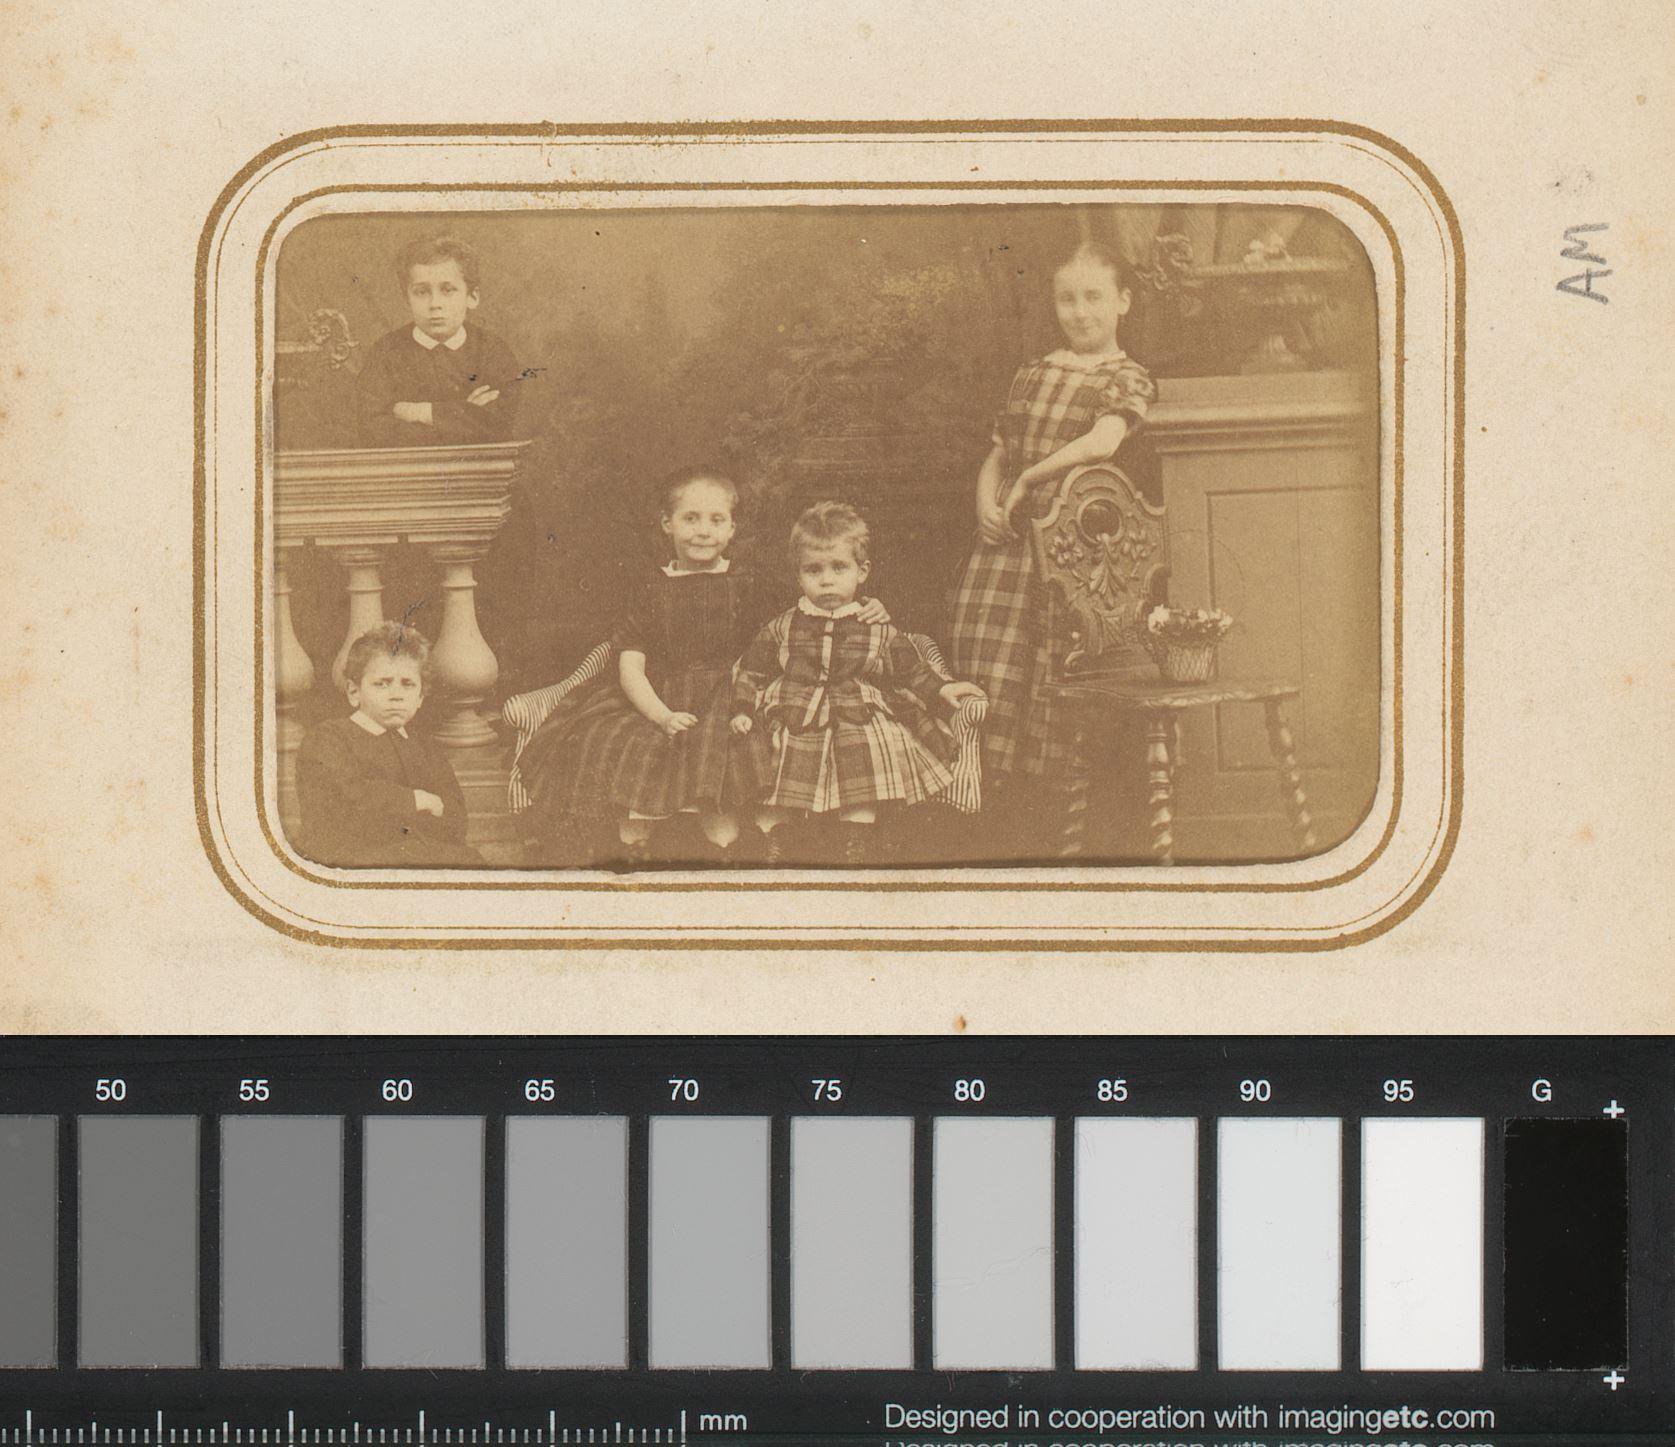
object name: carte de visite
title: Groepsportret met vijf kinderen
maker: maurits verveer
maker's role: painter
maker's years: 1817-1903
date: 1861-1883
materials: cardboard, photographic support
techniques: albumen print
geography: the hague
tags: child, anonymous historical persons portrayed in a group, in a group-portrait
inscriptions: inscription: ‘M. Verveer/ Photographe/ 52, Zeestraat, 52/ vis a vis du Willemspark/ La Haye’